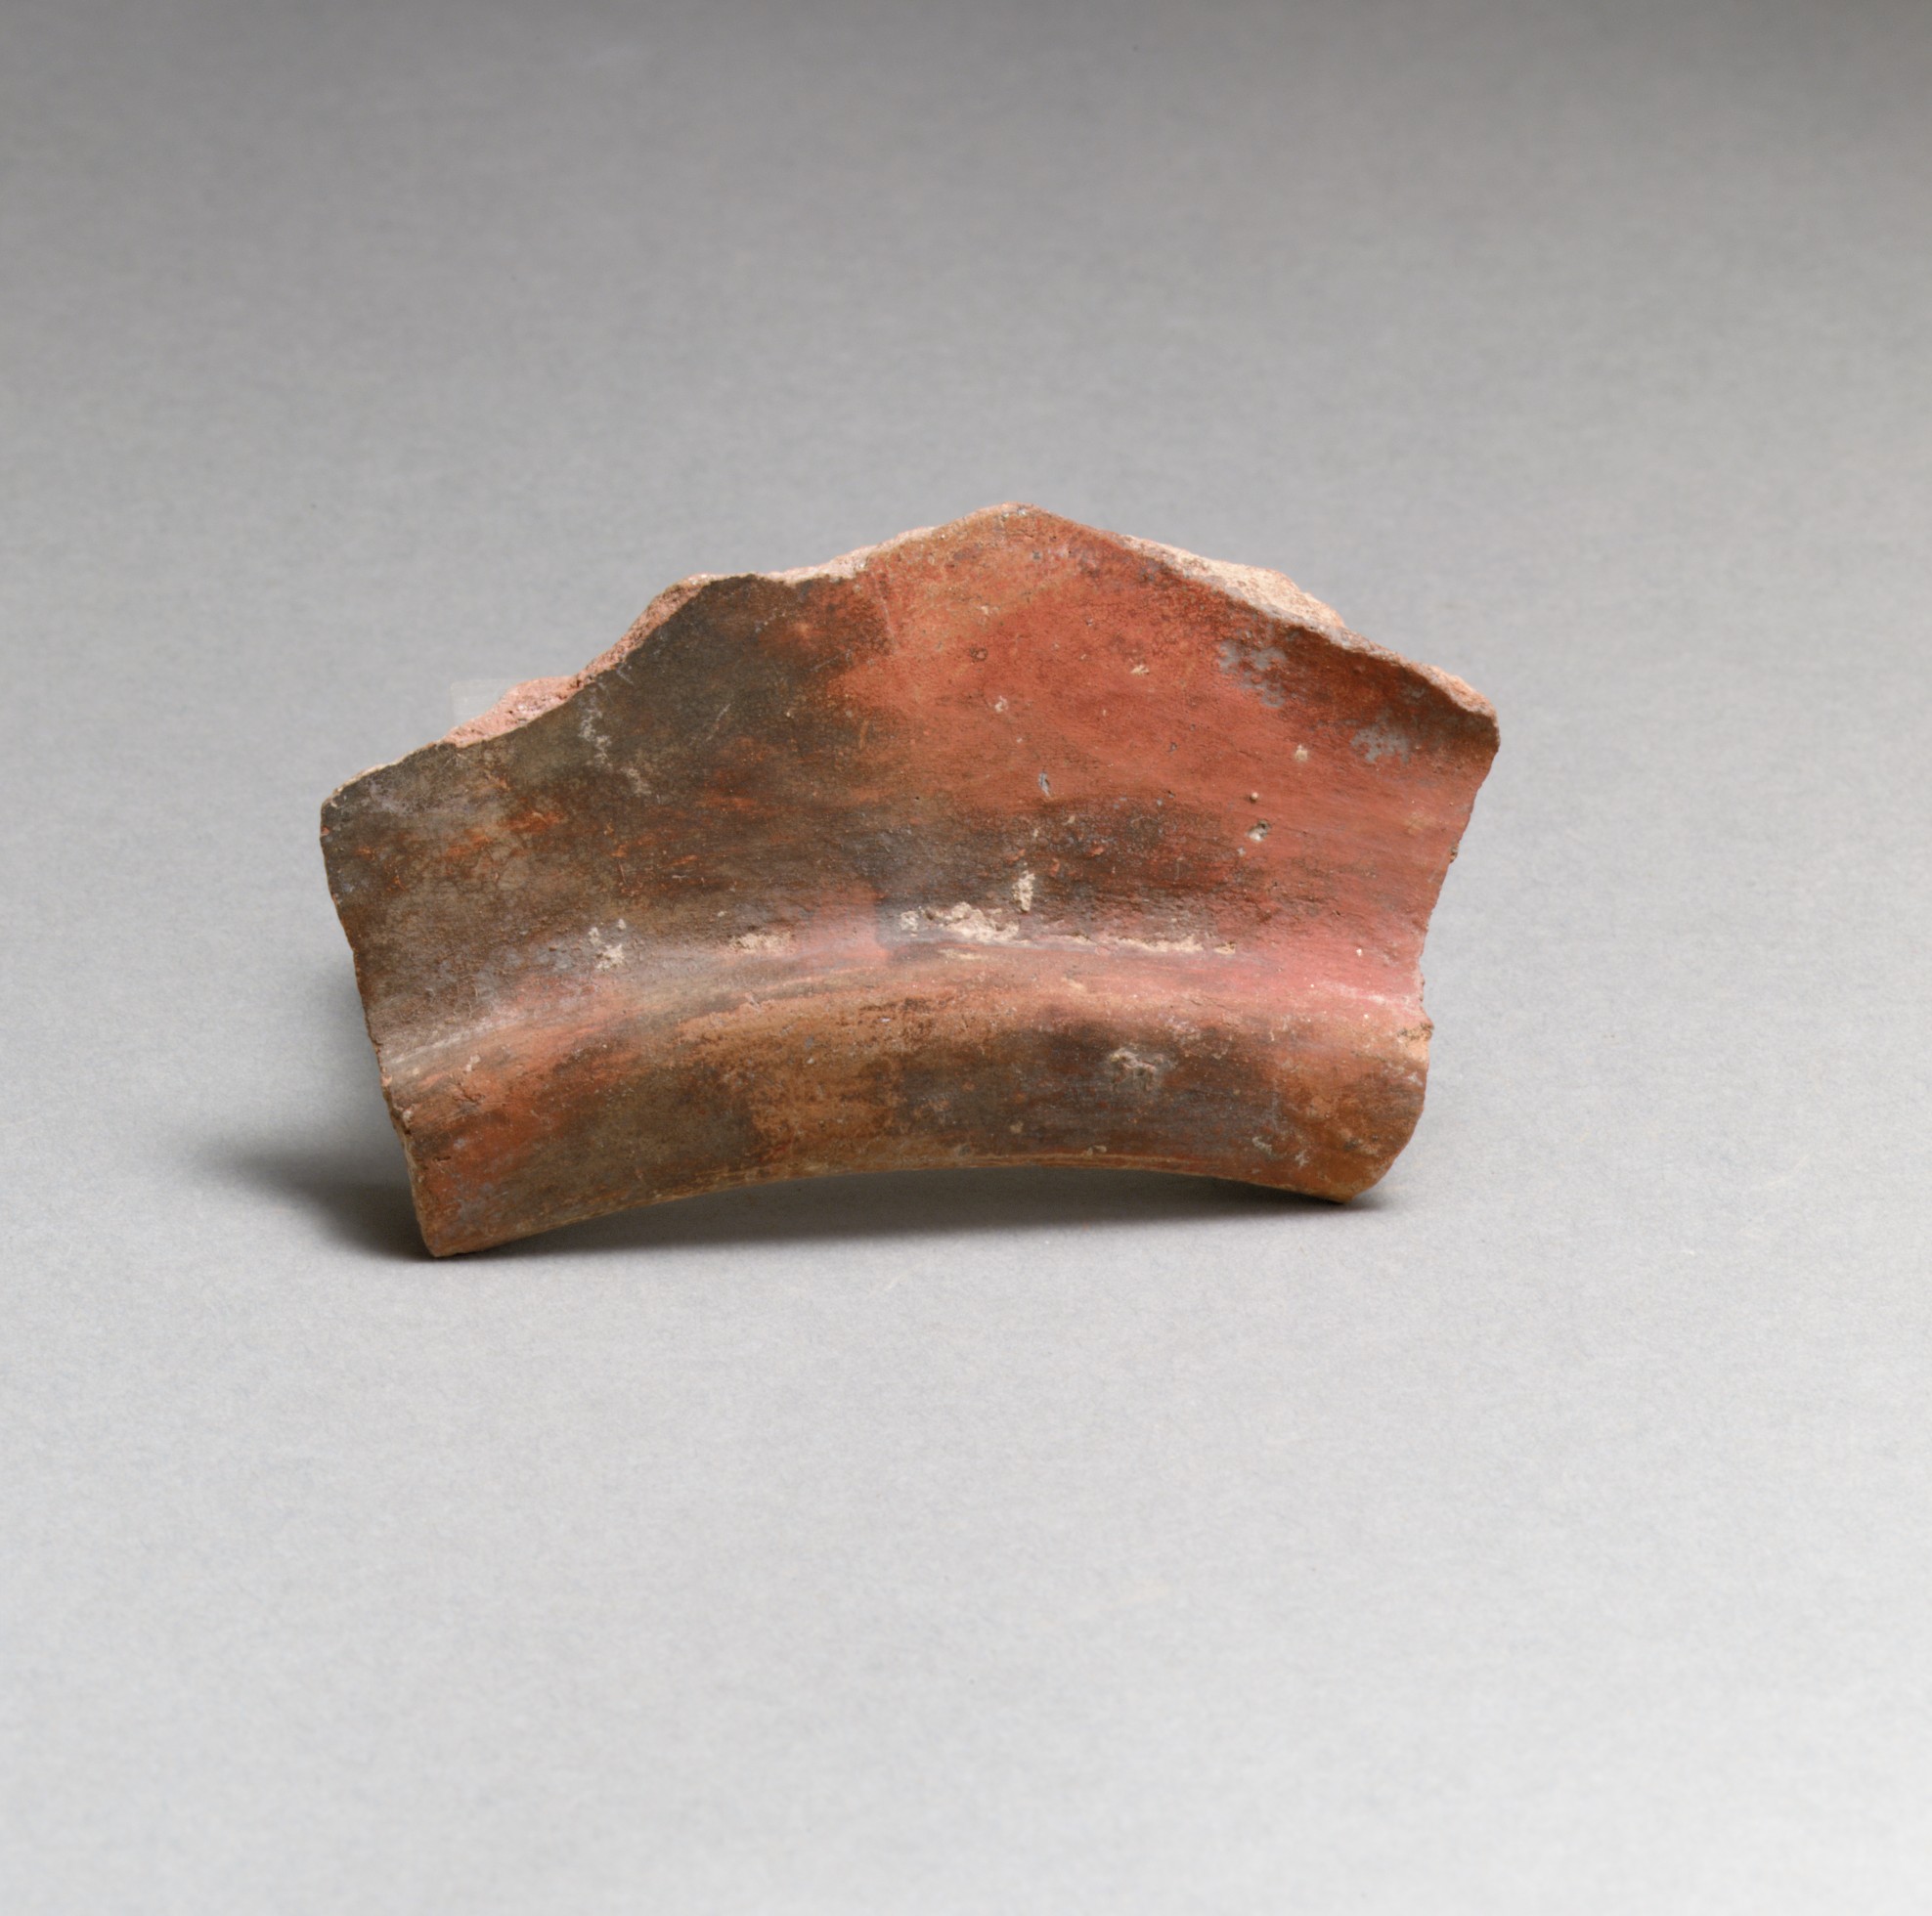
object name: vase fragment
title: Two terracotta rim fragments from a closed vase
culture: minoan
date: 2900-2300 BCE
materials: terracotta